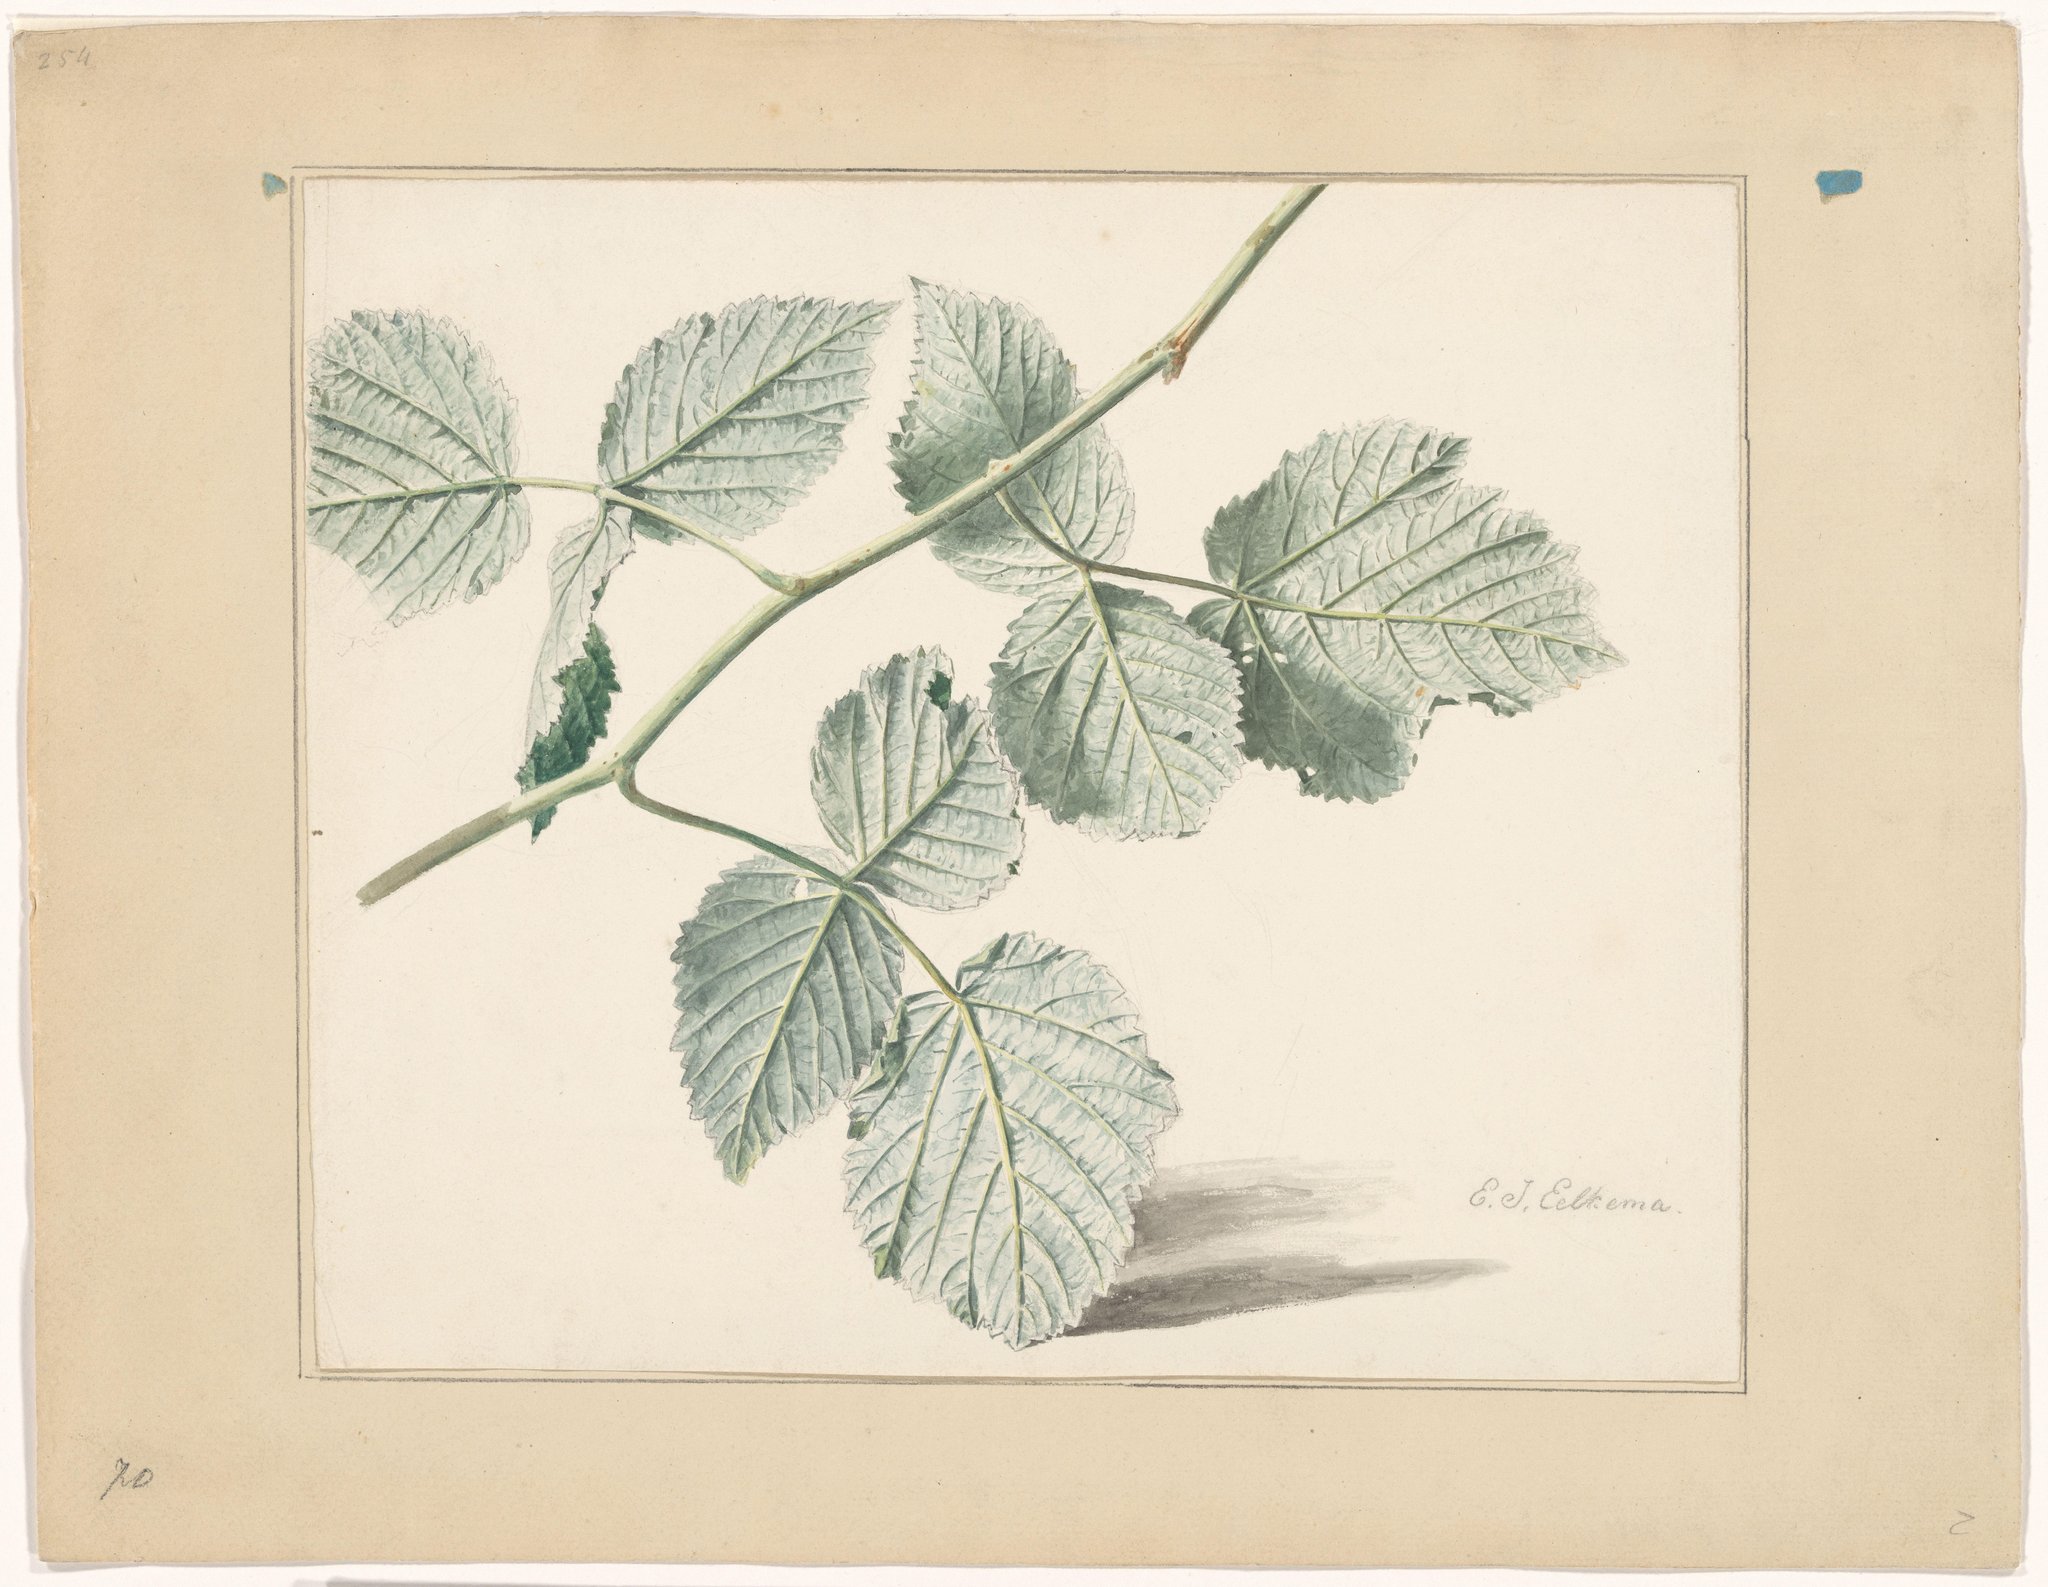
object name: drawing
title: Achterkant van een tak van een framboosstruik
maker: eelke jelles eelkema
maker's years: 1788-1839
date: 1815-1830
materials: paper, watercolor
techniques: brush, drawing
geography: netherlands